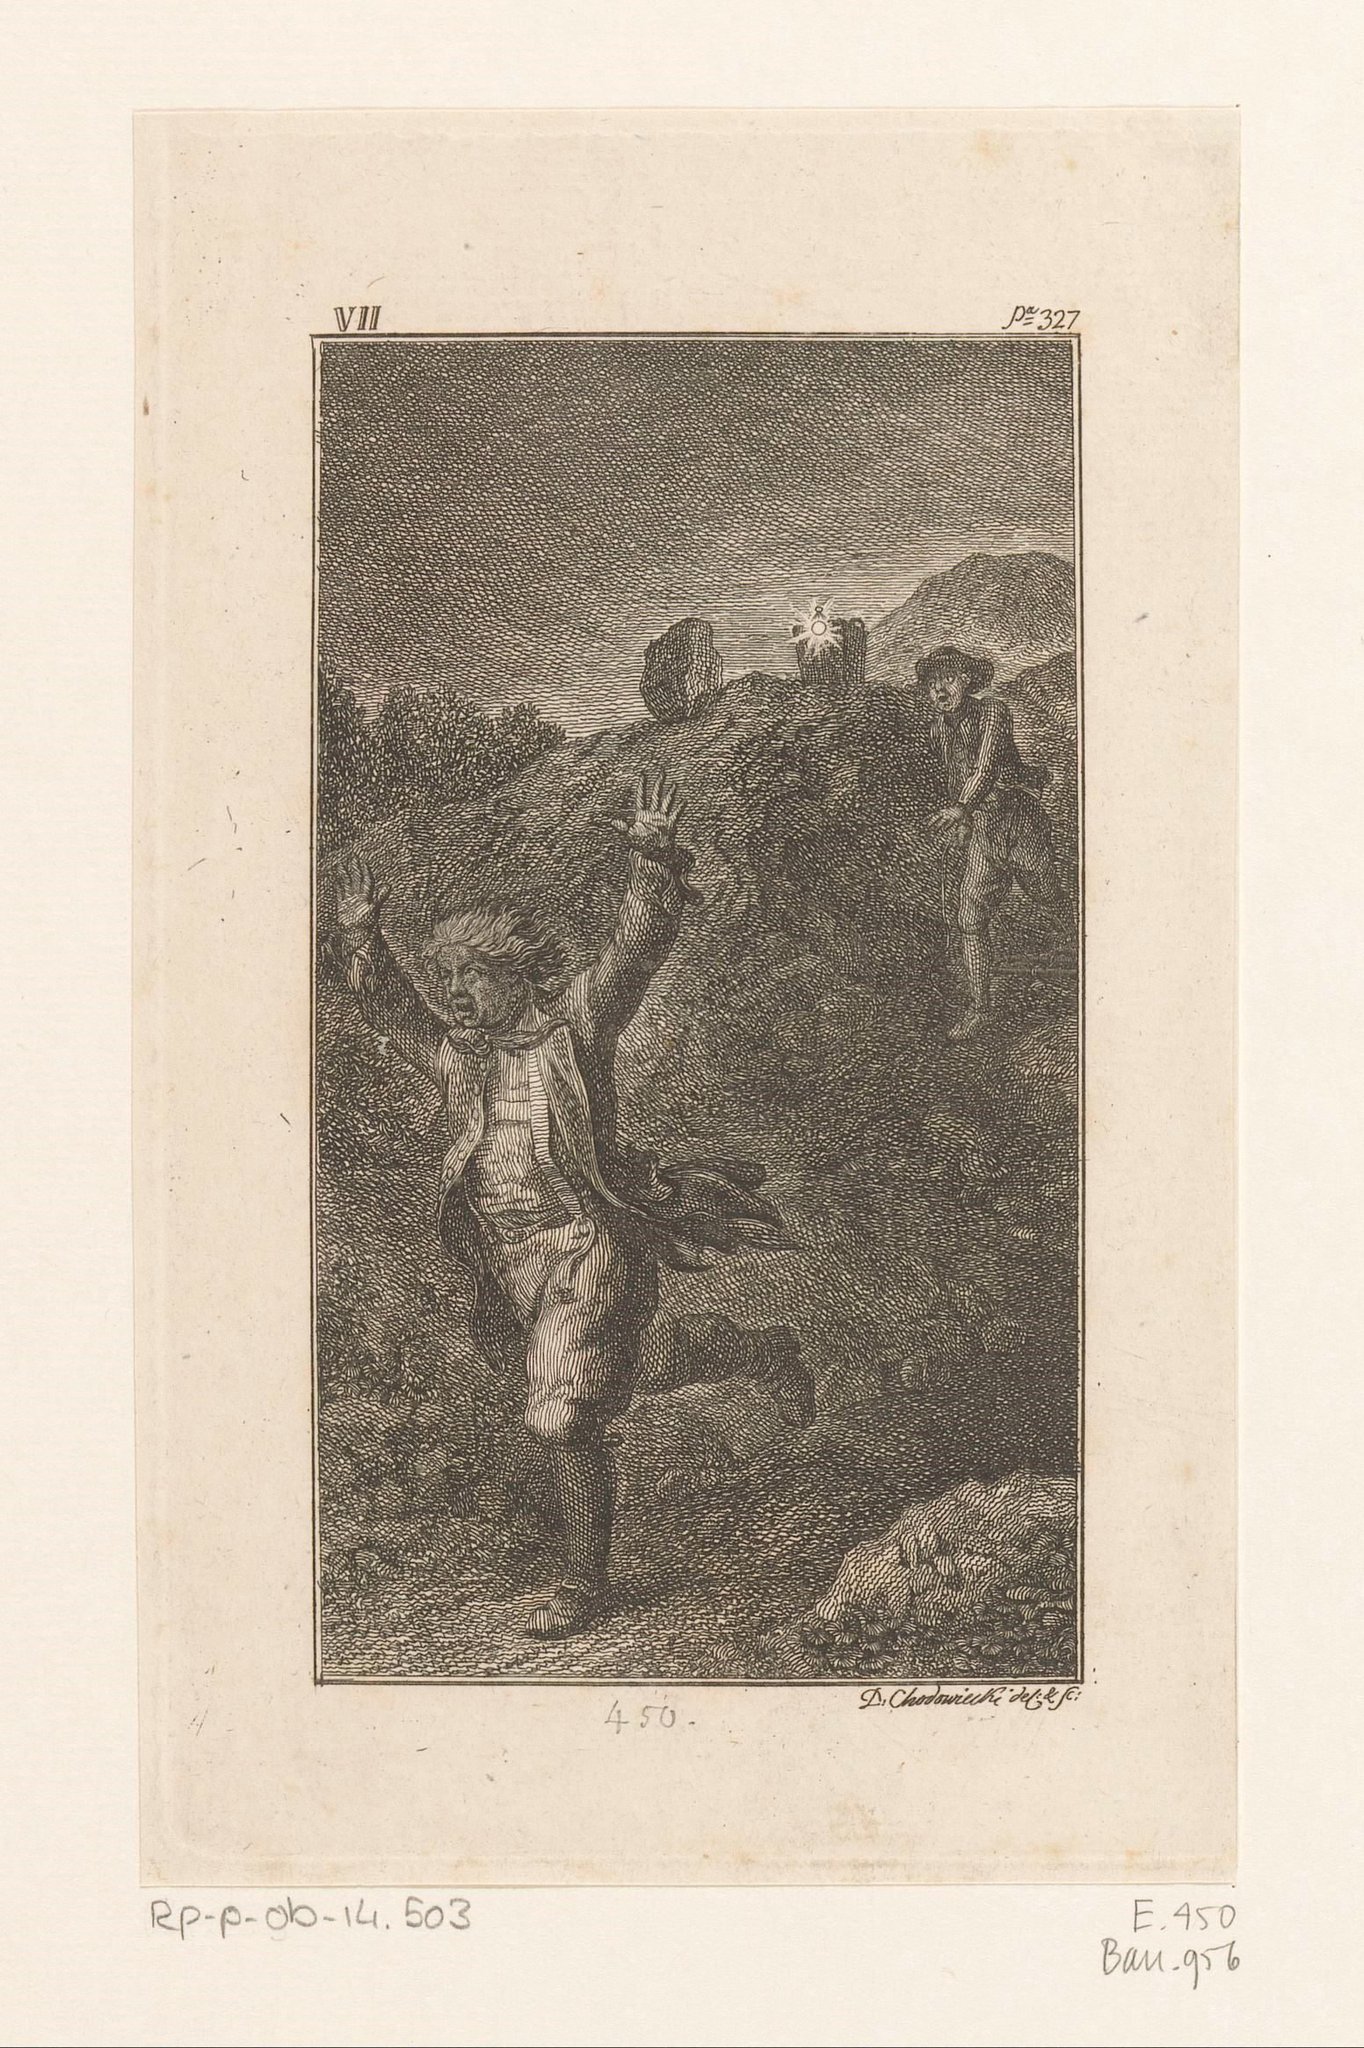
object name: print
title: Himmel rent weg in paniek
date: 1782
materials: paper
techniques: etching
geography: berlin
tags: politician, flight, running away; pursuing, fear, dread; 'paura', 'timidità o timore', 'timore' (ripa), lantern, night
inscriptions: collector's mark: Lugt 2228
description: Prent gebruikt voor: Pestalozzi, Johann Heinrich. Léonard et Gertrude ou Les moeurs villageoises, telles qu'on les retrouve à la ville & à la cour. Berlijn: George Jacques Decker, 1783.